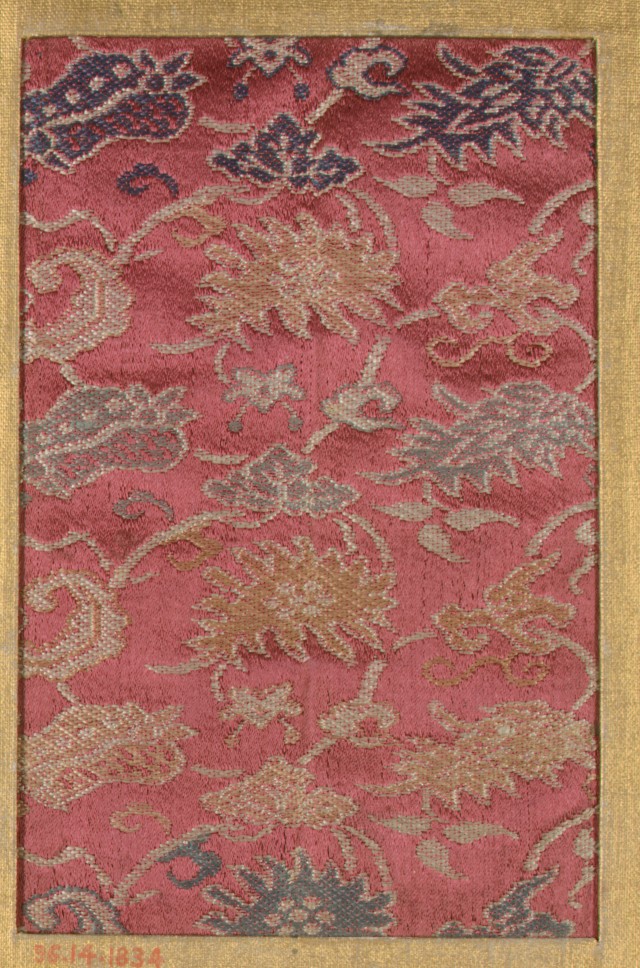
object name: piece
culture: japanese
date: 1701-1900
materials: silk